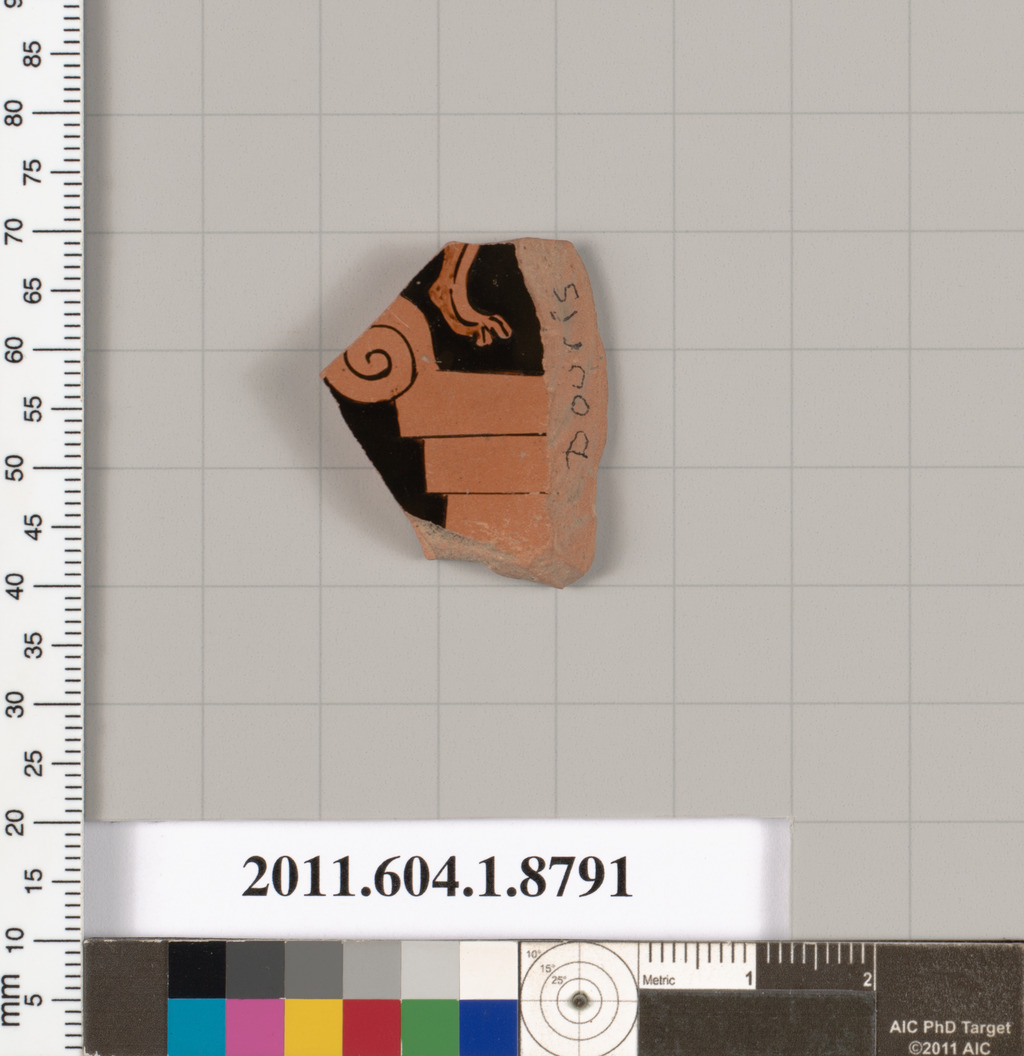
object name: kylix fragment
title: Terracotta fragment of a kylix (drinking cup)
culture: greek, attic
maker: douris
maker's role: artist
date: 490-480 BCE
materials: terracotta